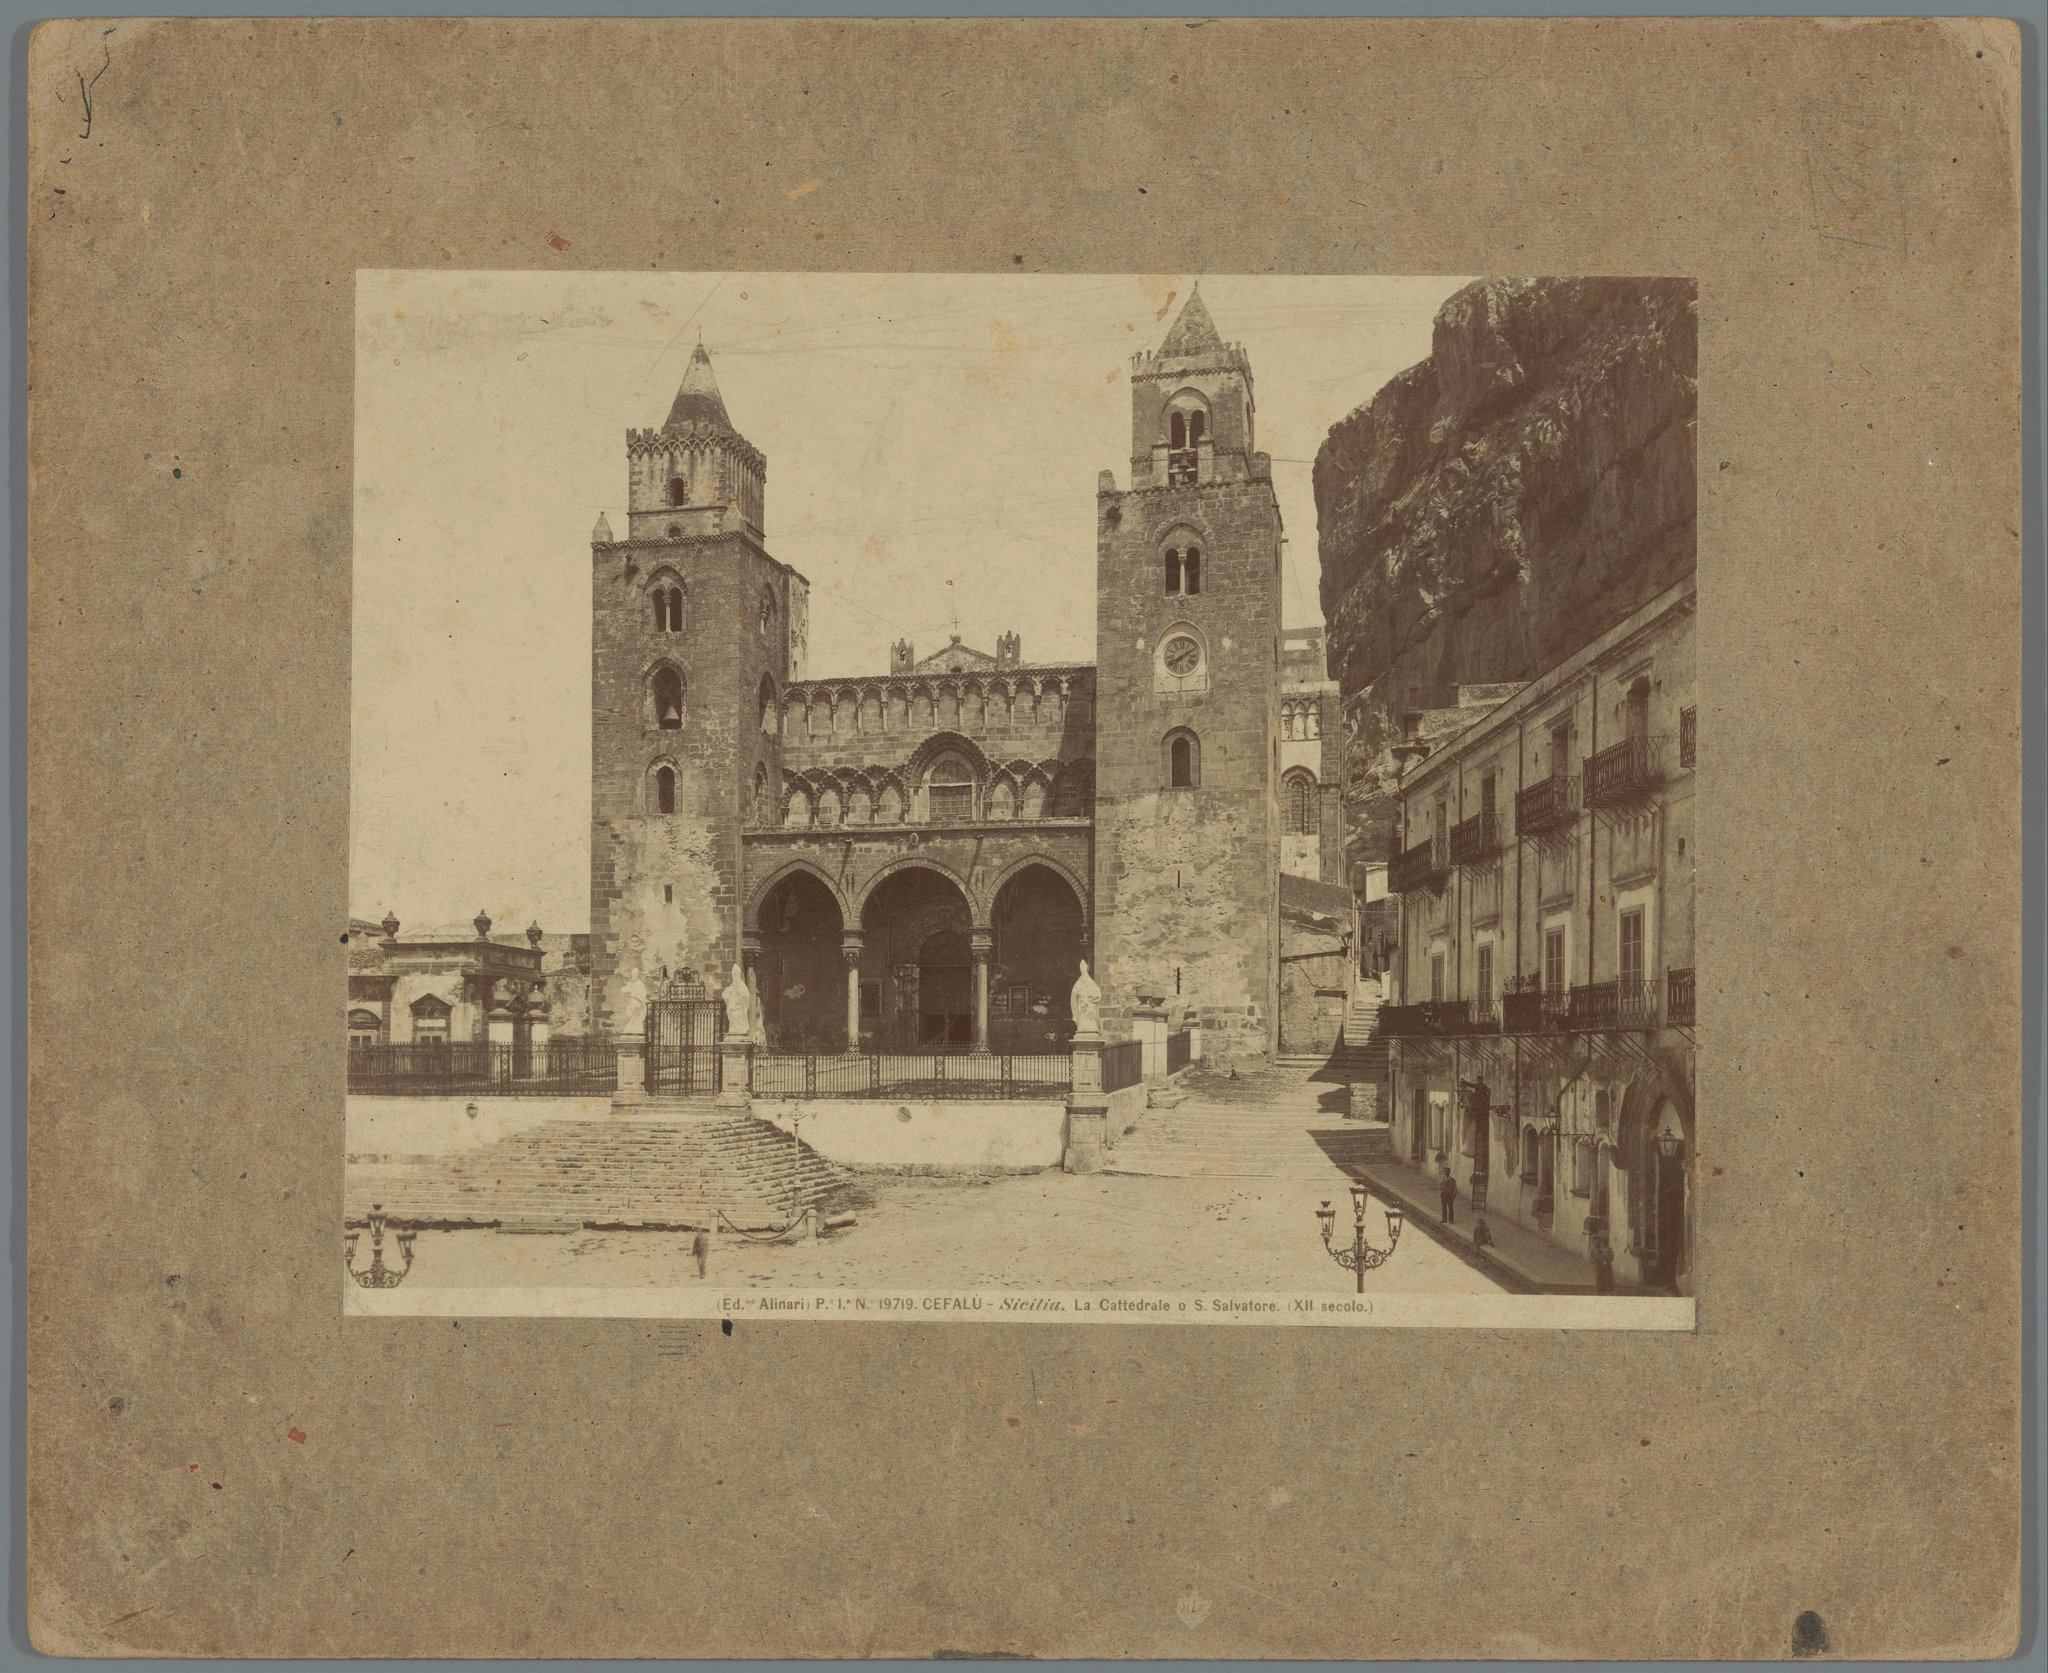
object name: photograph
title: CEFALÙ - Sicilia. La Cattedrale o S. Salvatore. (XII secolo)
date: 1875-1900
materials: cardboard, photographic support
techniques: albumen print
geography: cefalù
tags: tower, clock tower ~ monumental adornment, church (exterior)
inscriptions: collector's mark: Lugt 3937, inscription: ‘O.C. 66’, number: ‘P.e I.a N.o 19719.’